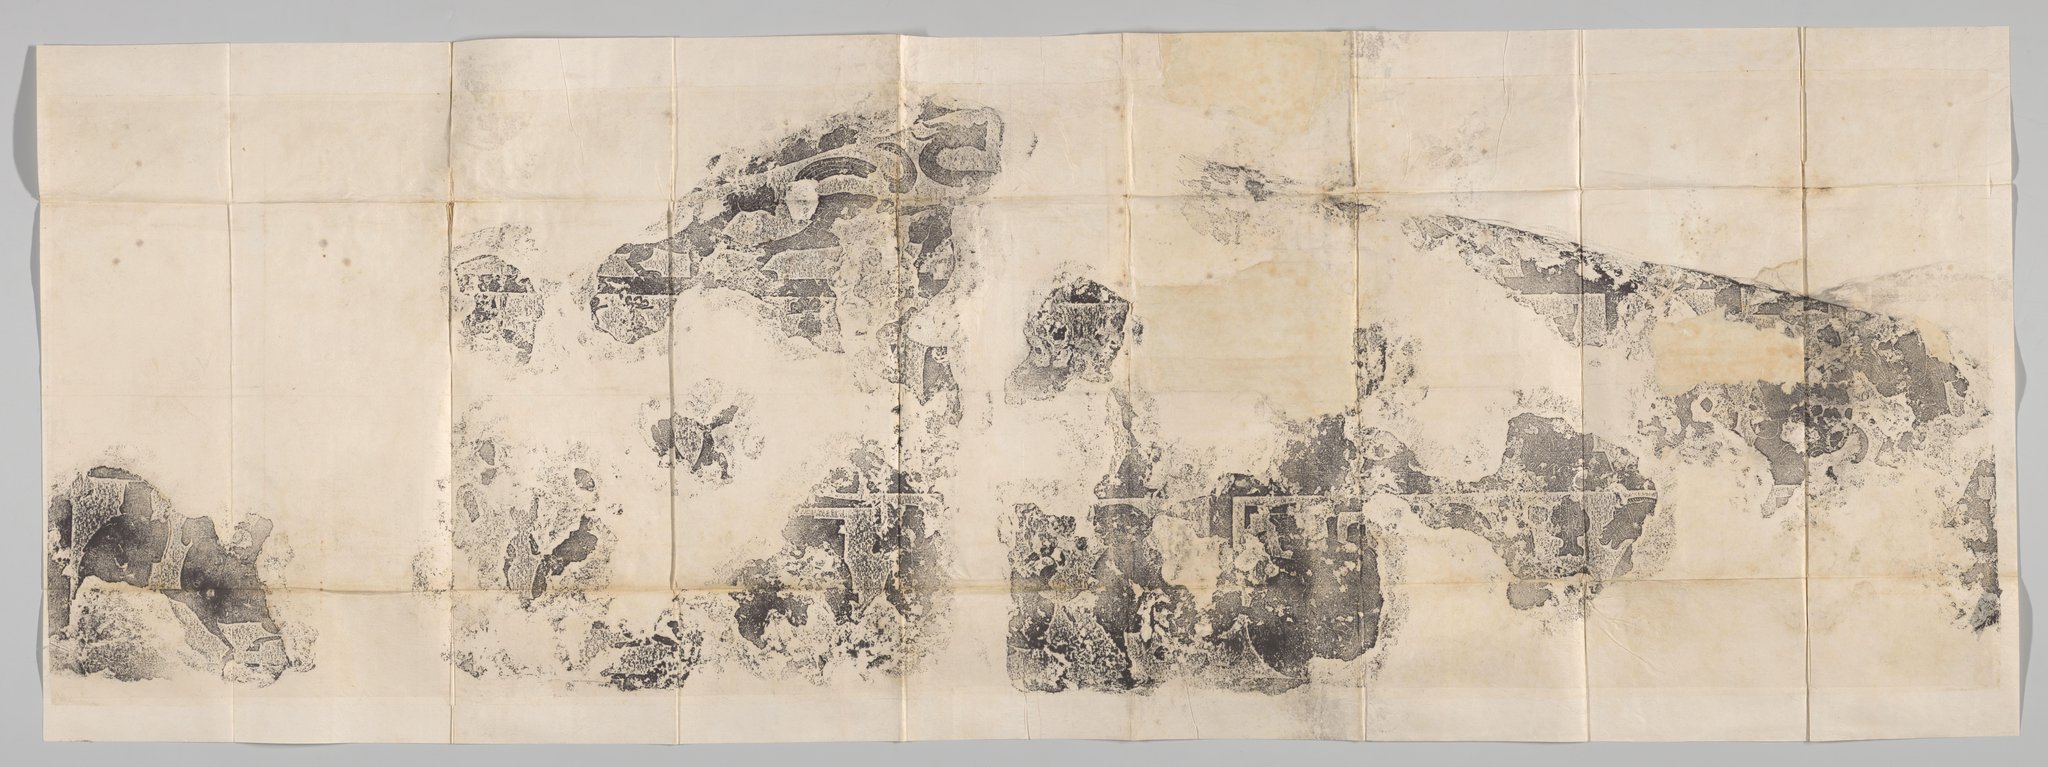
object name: wrijfprent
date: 1900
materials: ink, paper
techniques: rubbing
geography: china